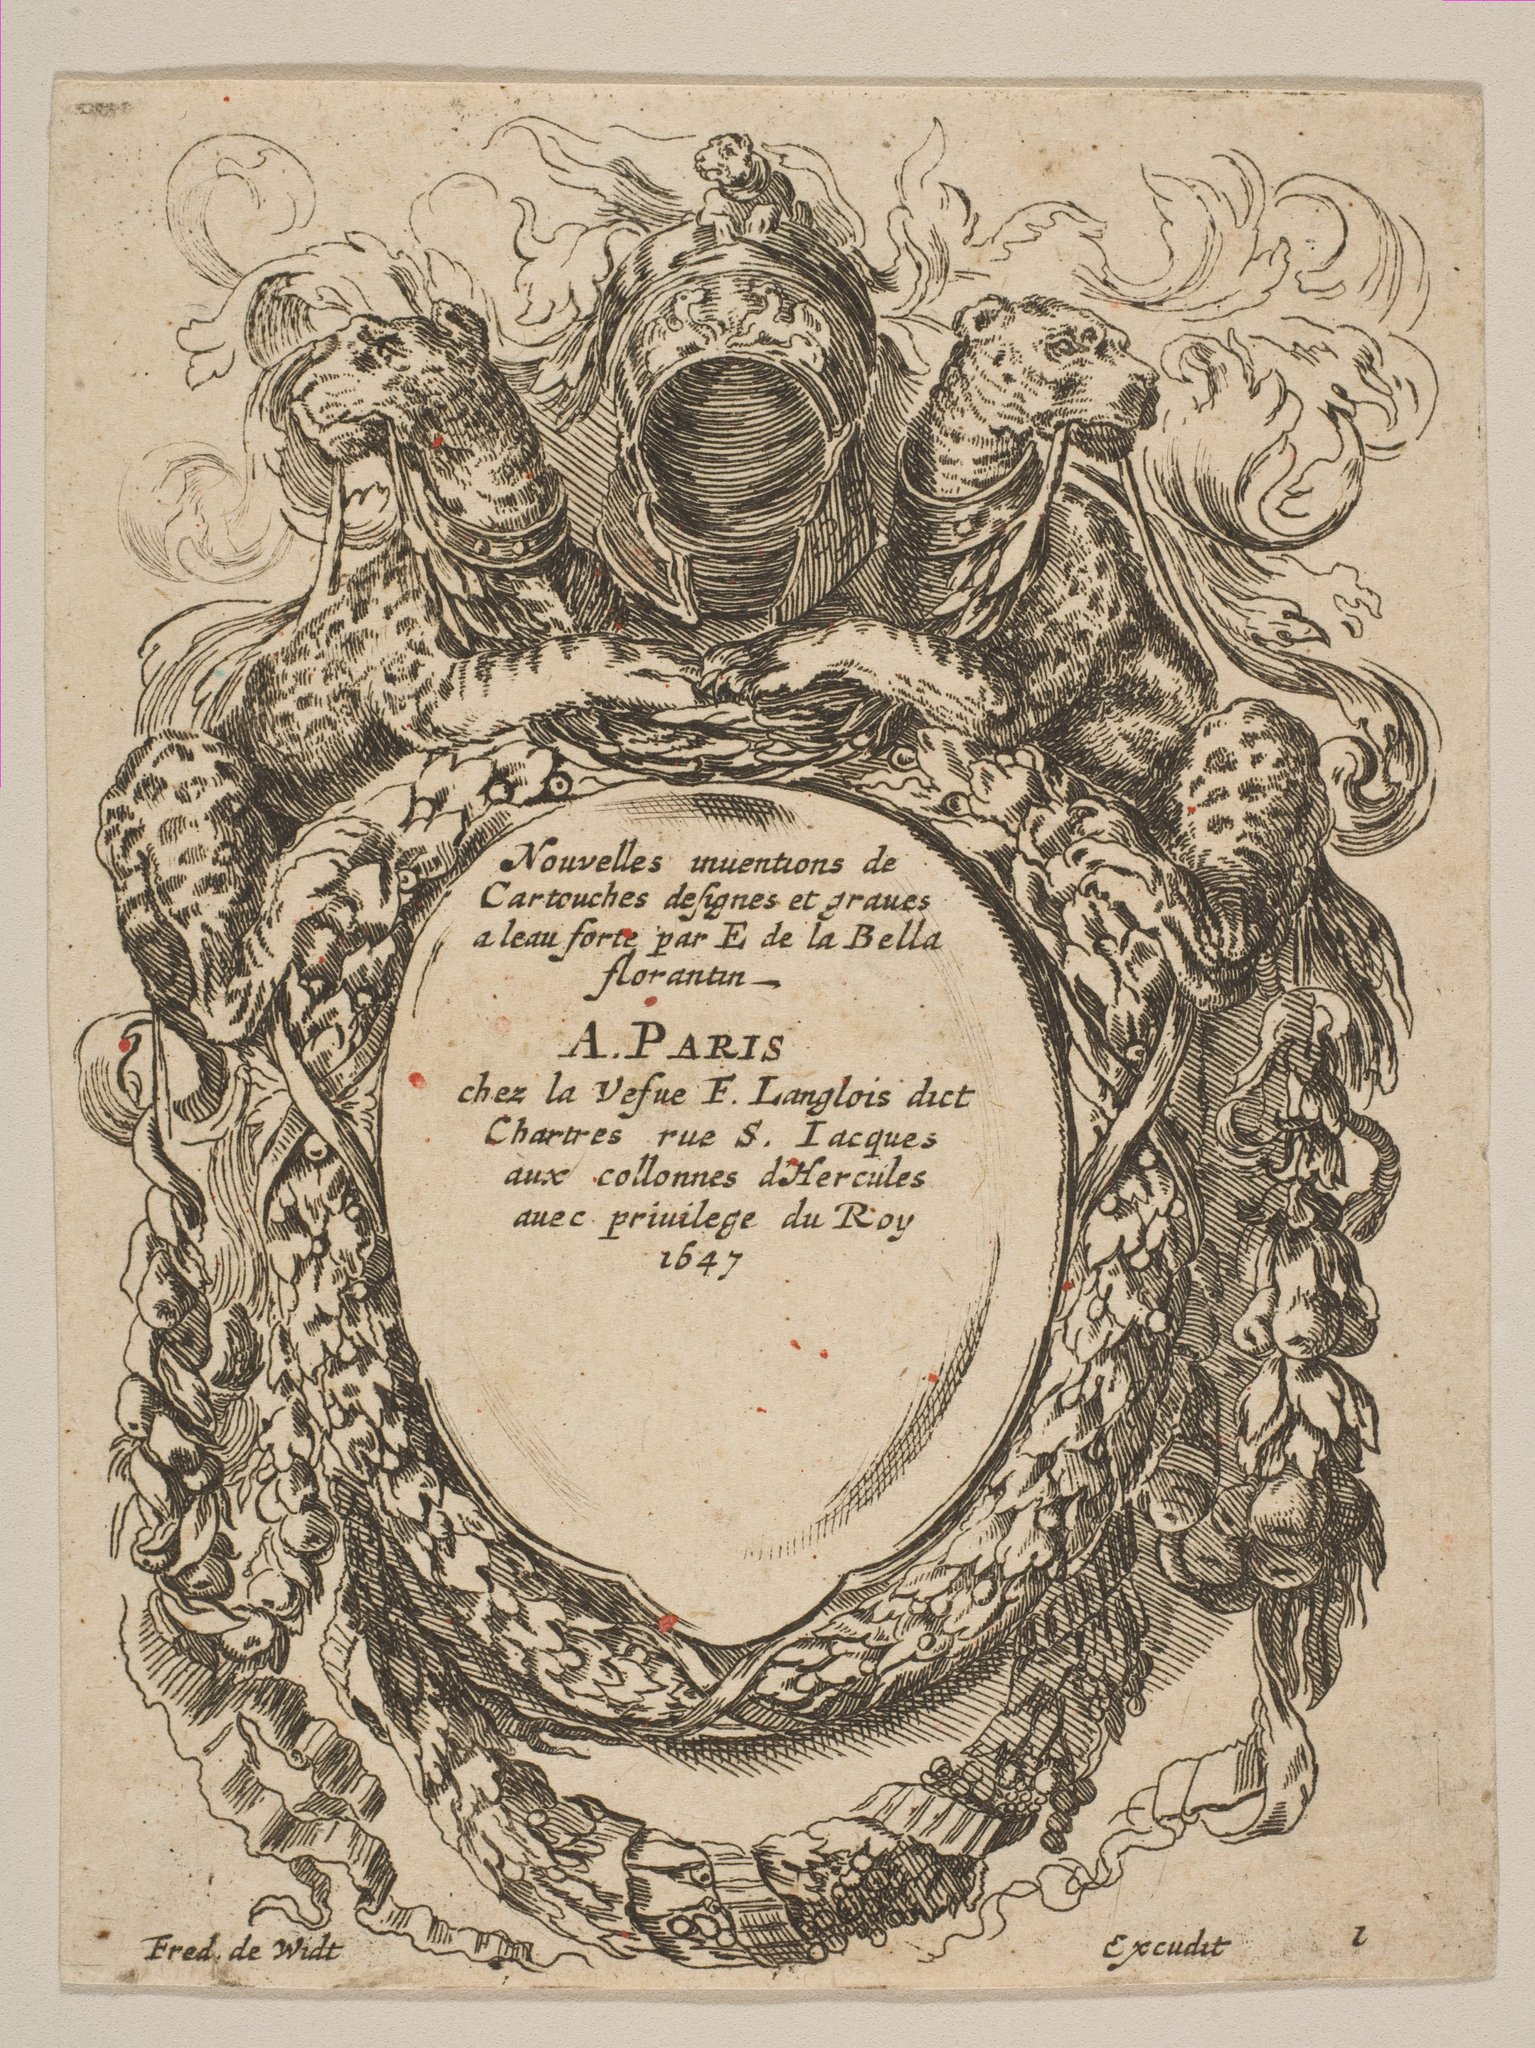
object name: print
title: Cartouche with Title: Nouvelles inventions de Cartouches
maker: anonymous, 17th century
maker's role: artist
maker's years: 1600-1700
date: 1601-1700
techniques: etching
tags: cartouches,leopards